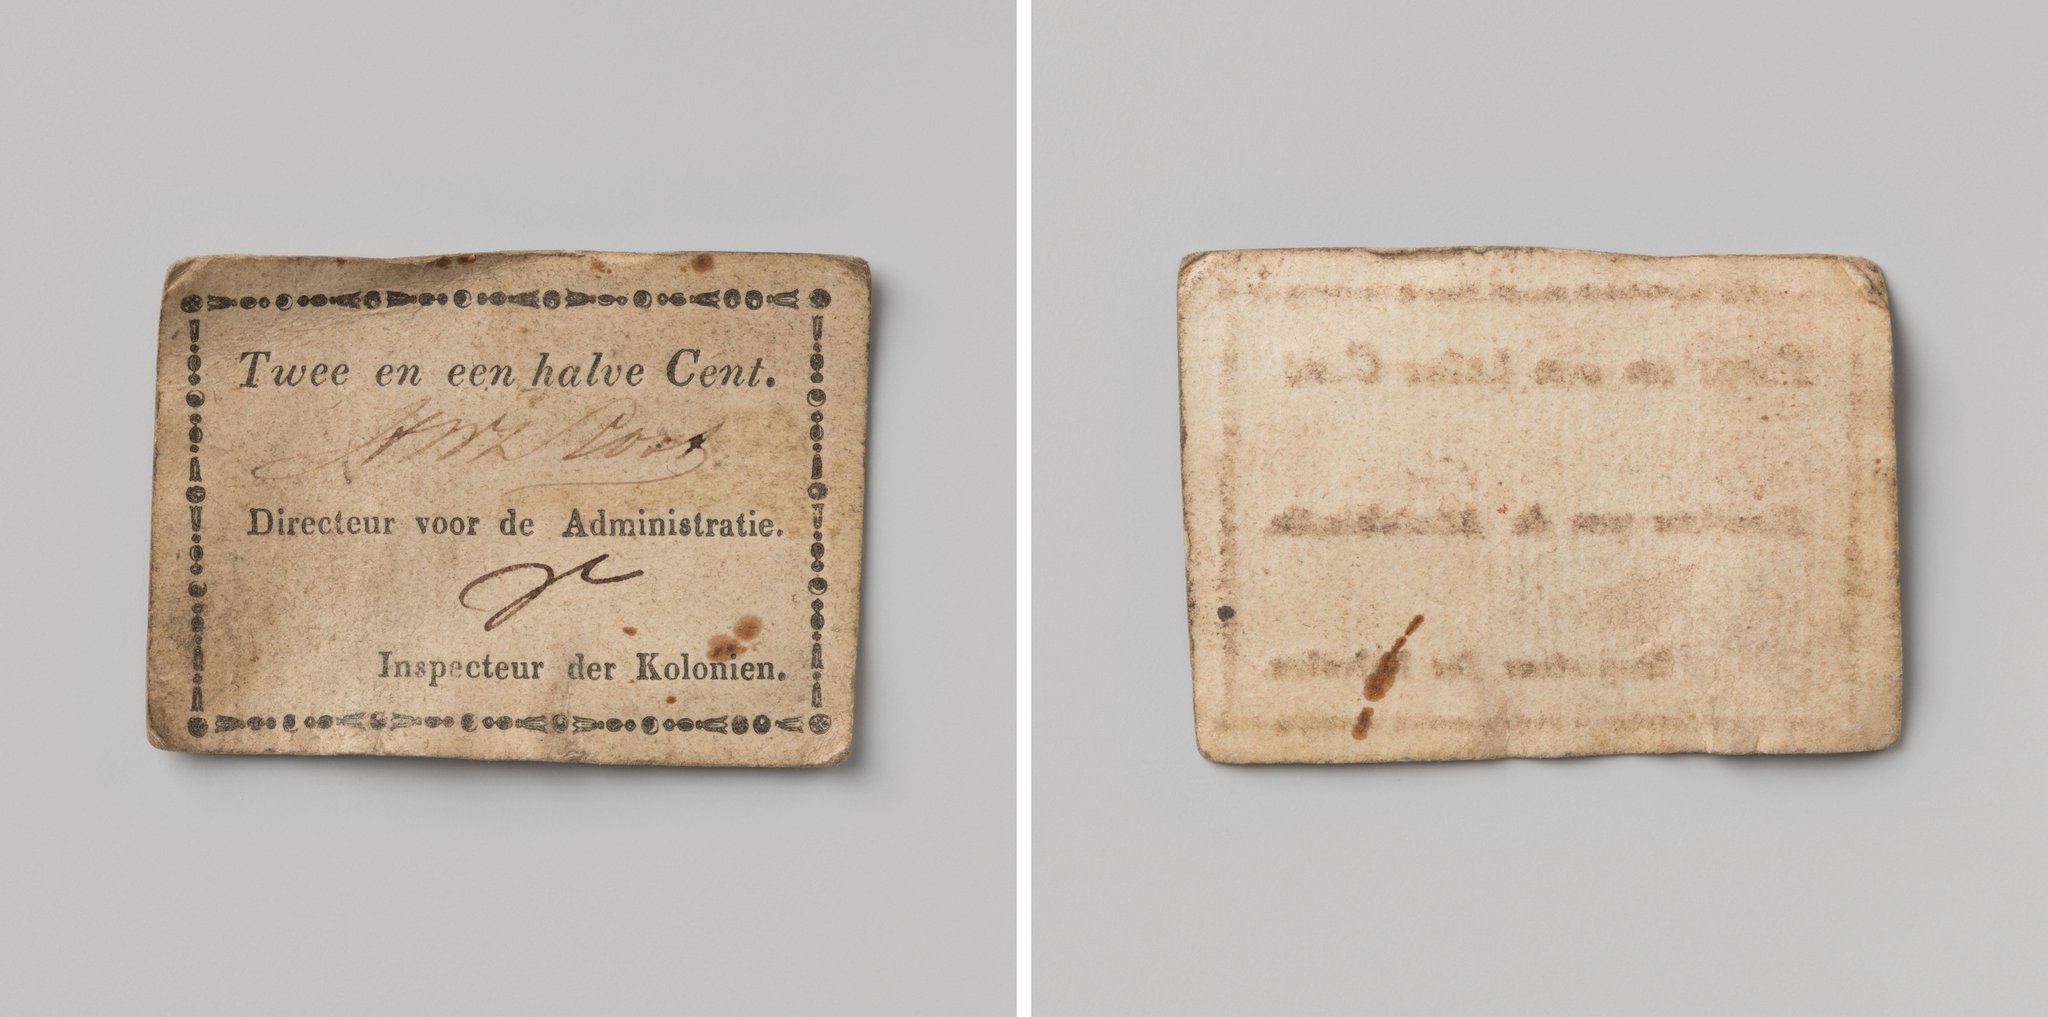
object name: waardepapier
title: Huismunt (winkelkaart) ter waarde van tweeeneenhalve cent, uitgegeven door de inspecteur der Kolonien vasn Weldadigheid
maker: Anonymous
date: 1830-1840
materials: cardboard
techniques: printing, writing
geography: frederiksoord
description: Eenzijdige, rechthoekige munt van wit karton. Voorzijde: binnen sierrand: gedrukt opschrift in drie regels; daartussen twee met zwarte inkt geschreven handtekeningen. Keerzijde: blanco.